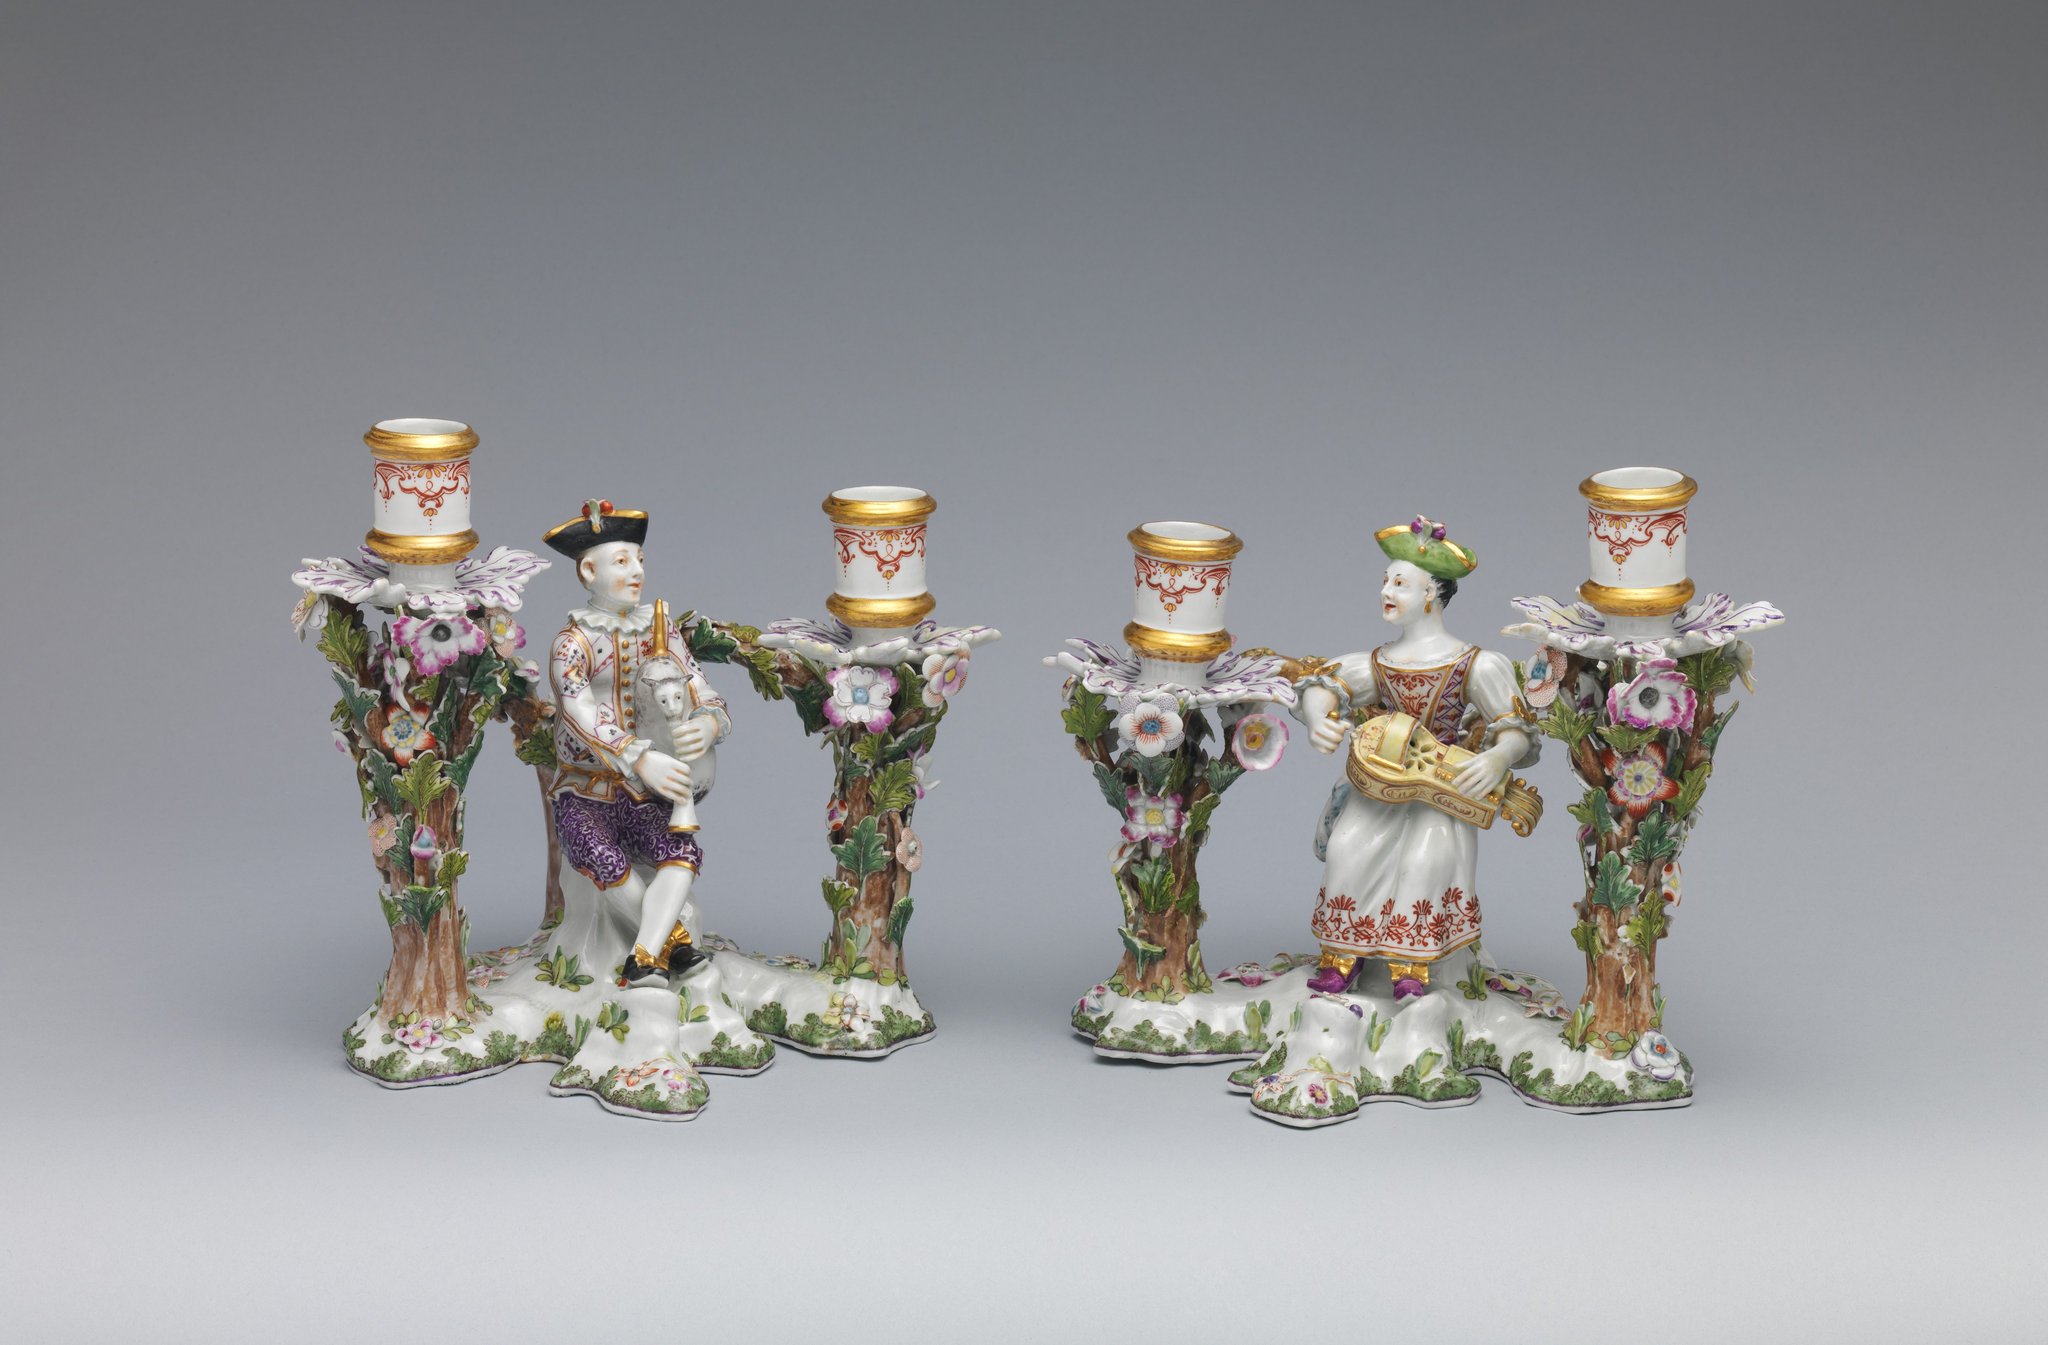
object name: candelabrum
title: Candelabrum (one of a pair)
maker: vienna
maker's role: manufactory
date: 1740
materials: hard paste porcelain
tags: musical instruments,men,women,musicians